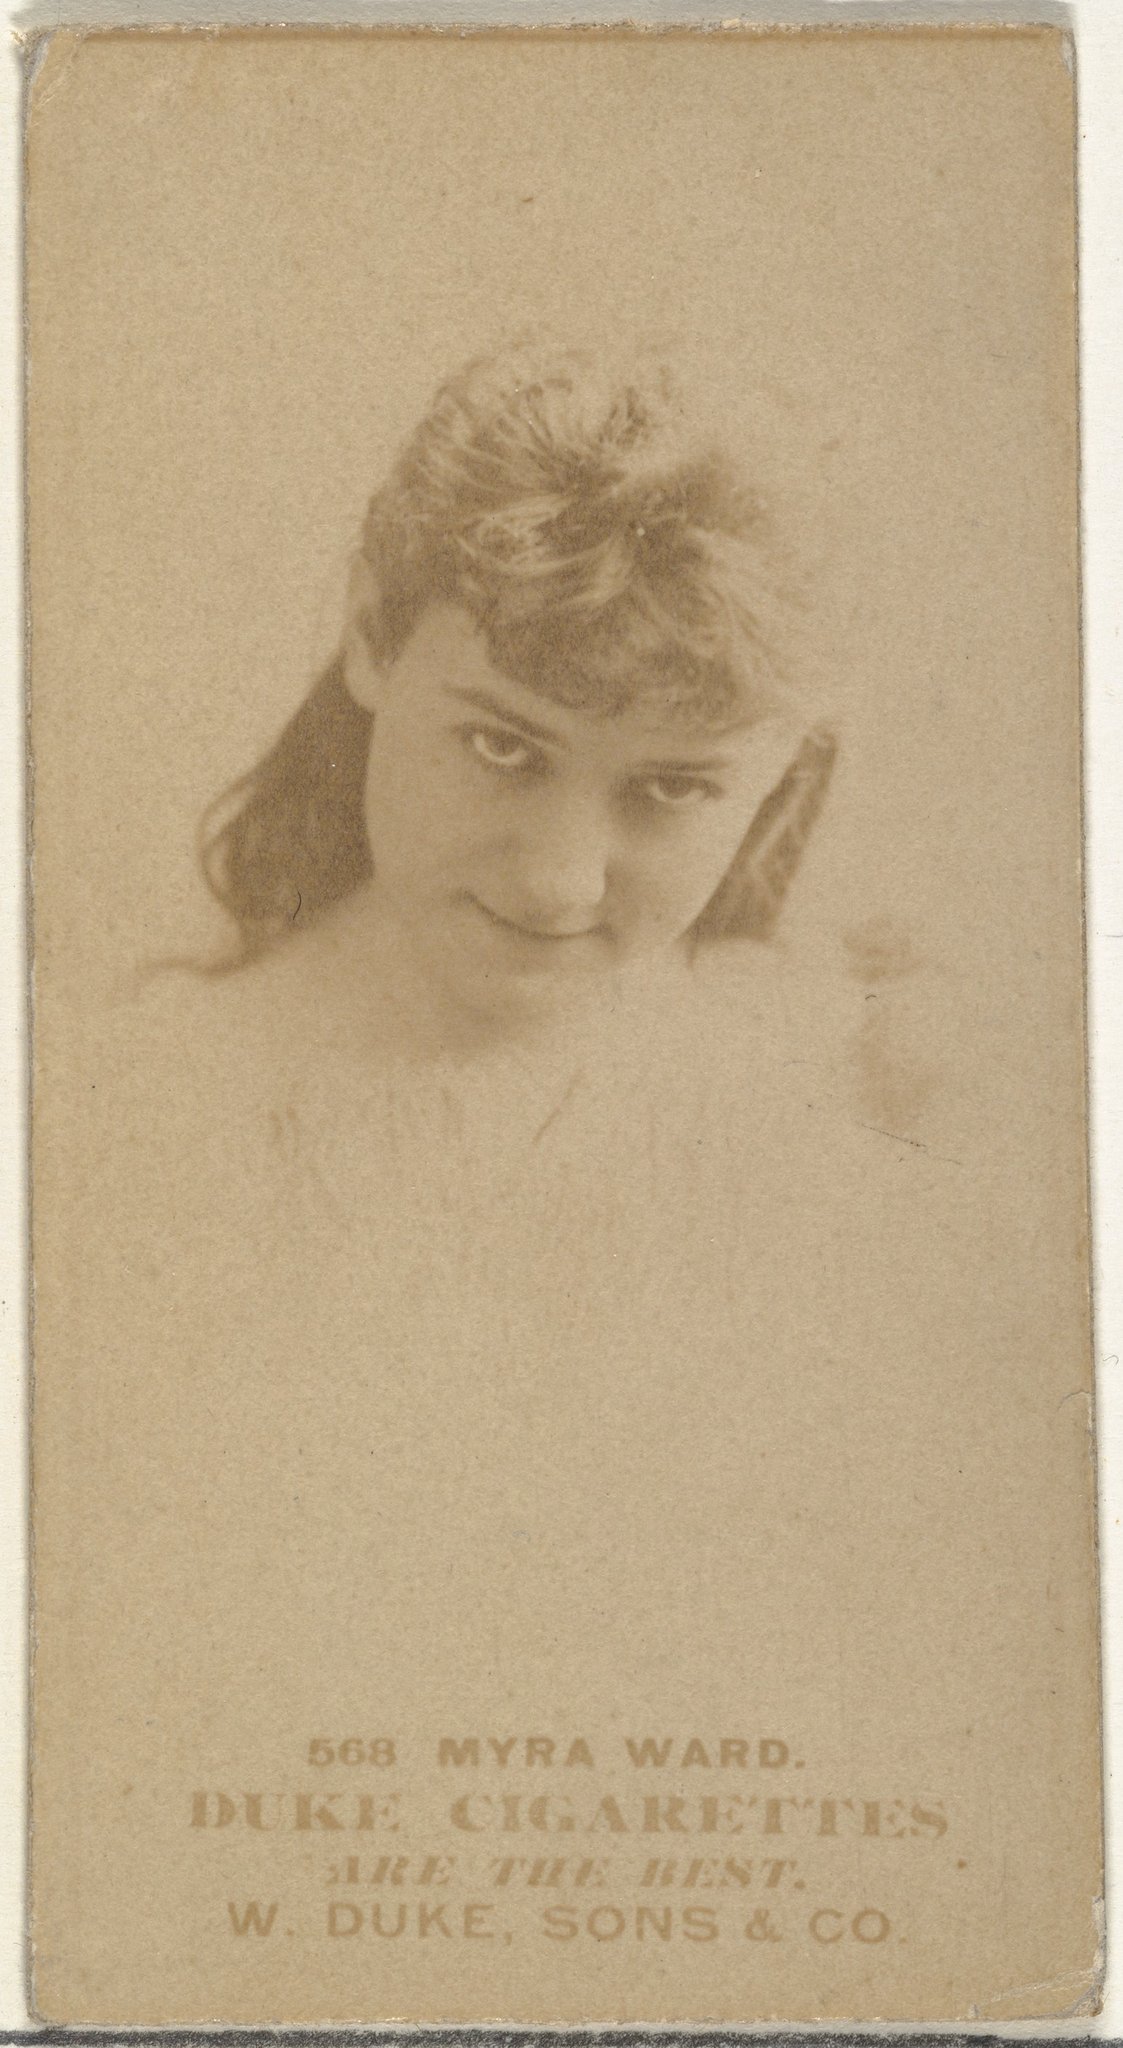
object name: photograph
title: Card Number 568, Myra Ward, from the Actors and Actresses series (N145-7) issued by Duke Sons & Co. to promote Duke Cigarettes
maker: w. duke, sons & co.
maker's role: publisher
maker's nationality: american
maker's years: 1870-1920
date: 1880-1889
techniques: albumen silver print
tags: portraits,women,actresses